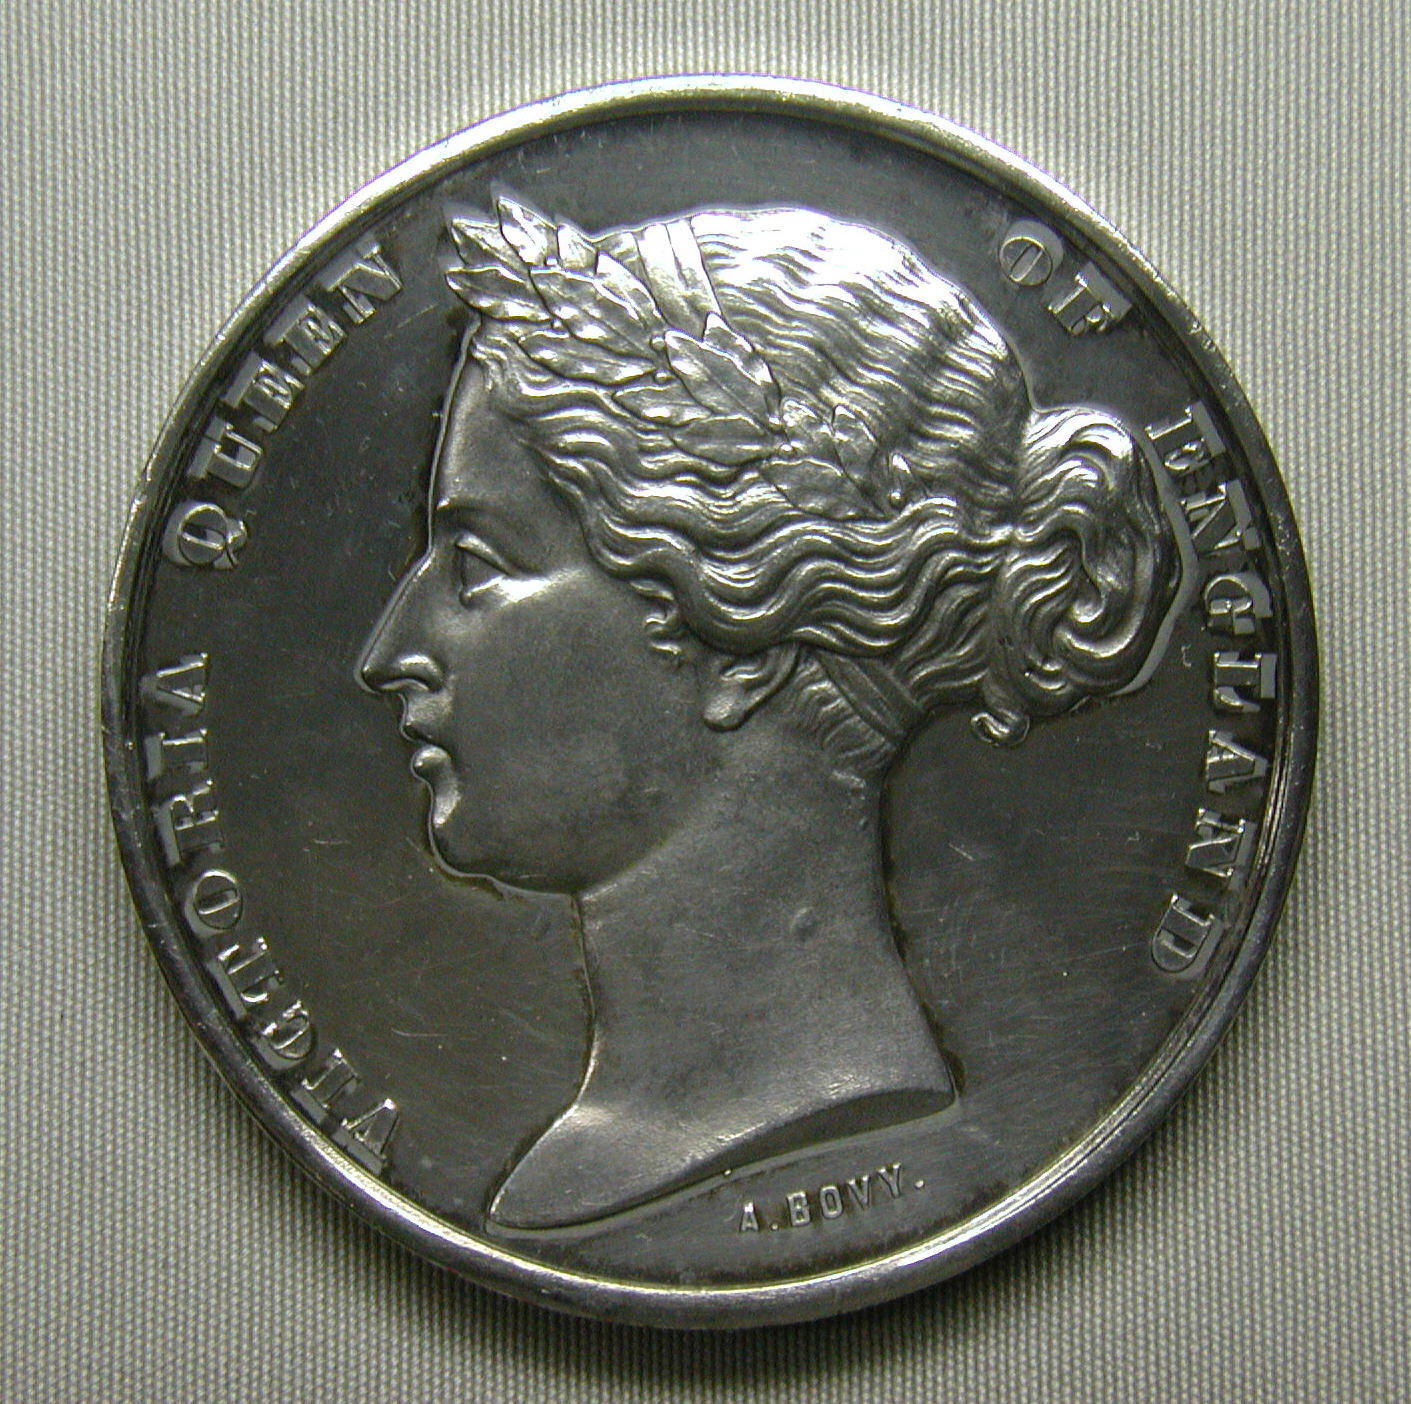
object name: medal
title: Universal Exhibition of London, 1862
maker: jean-françois-antoine bovy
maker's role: artist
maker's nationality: french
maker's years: 1795-1877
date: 1862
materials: silver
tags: palaces,profiles,women